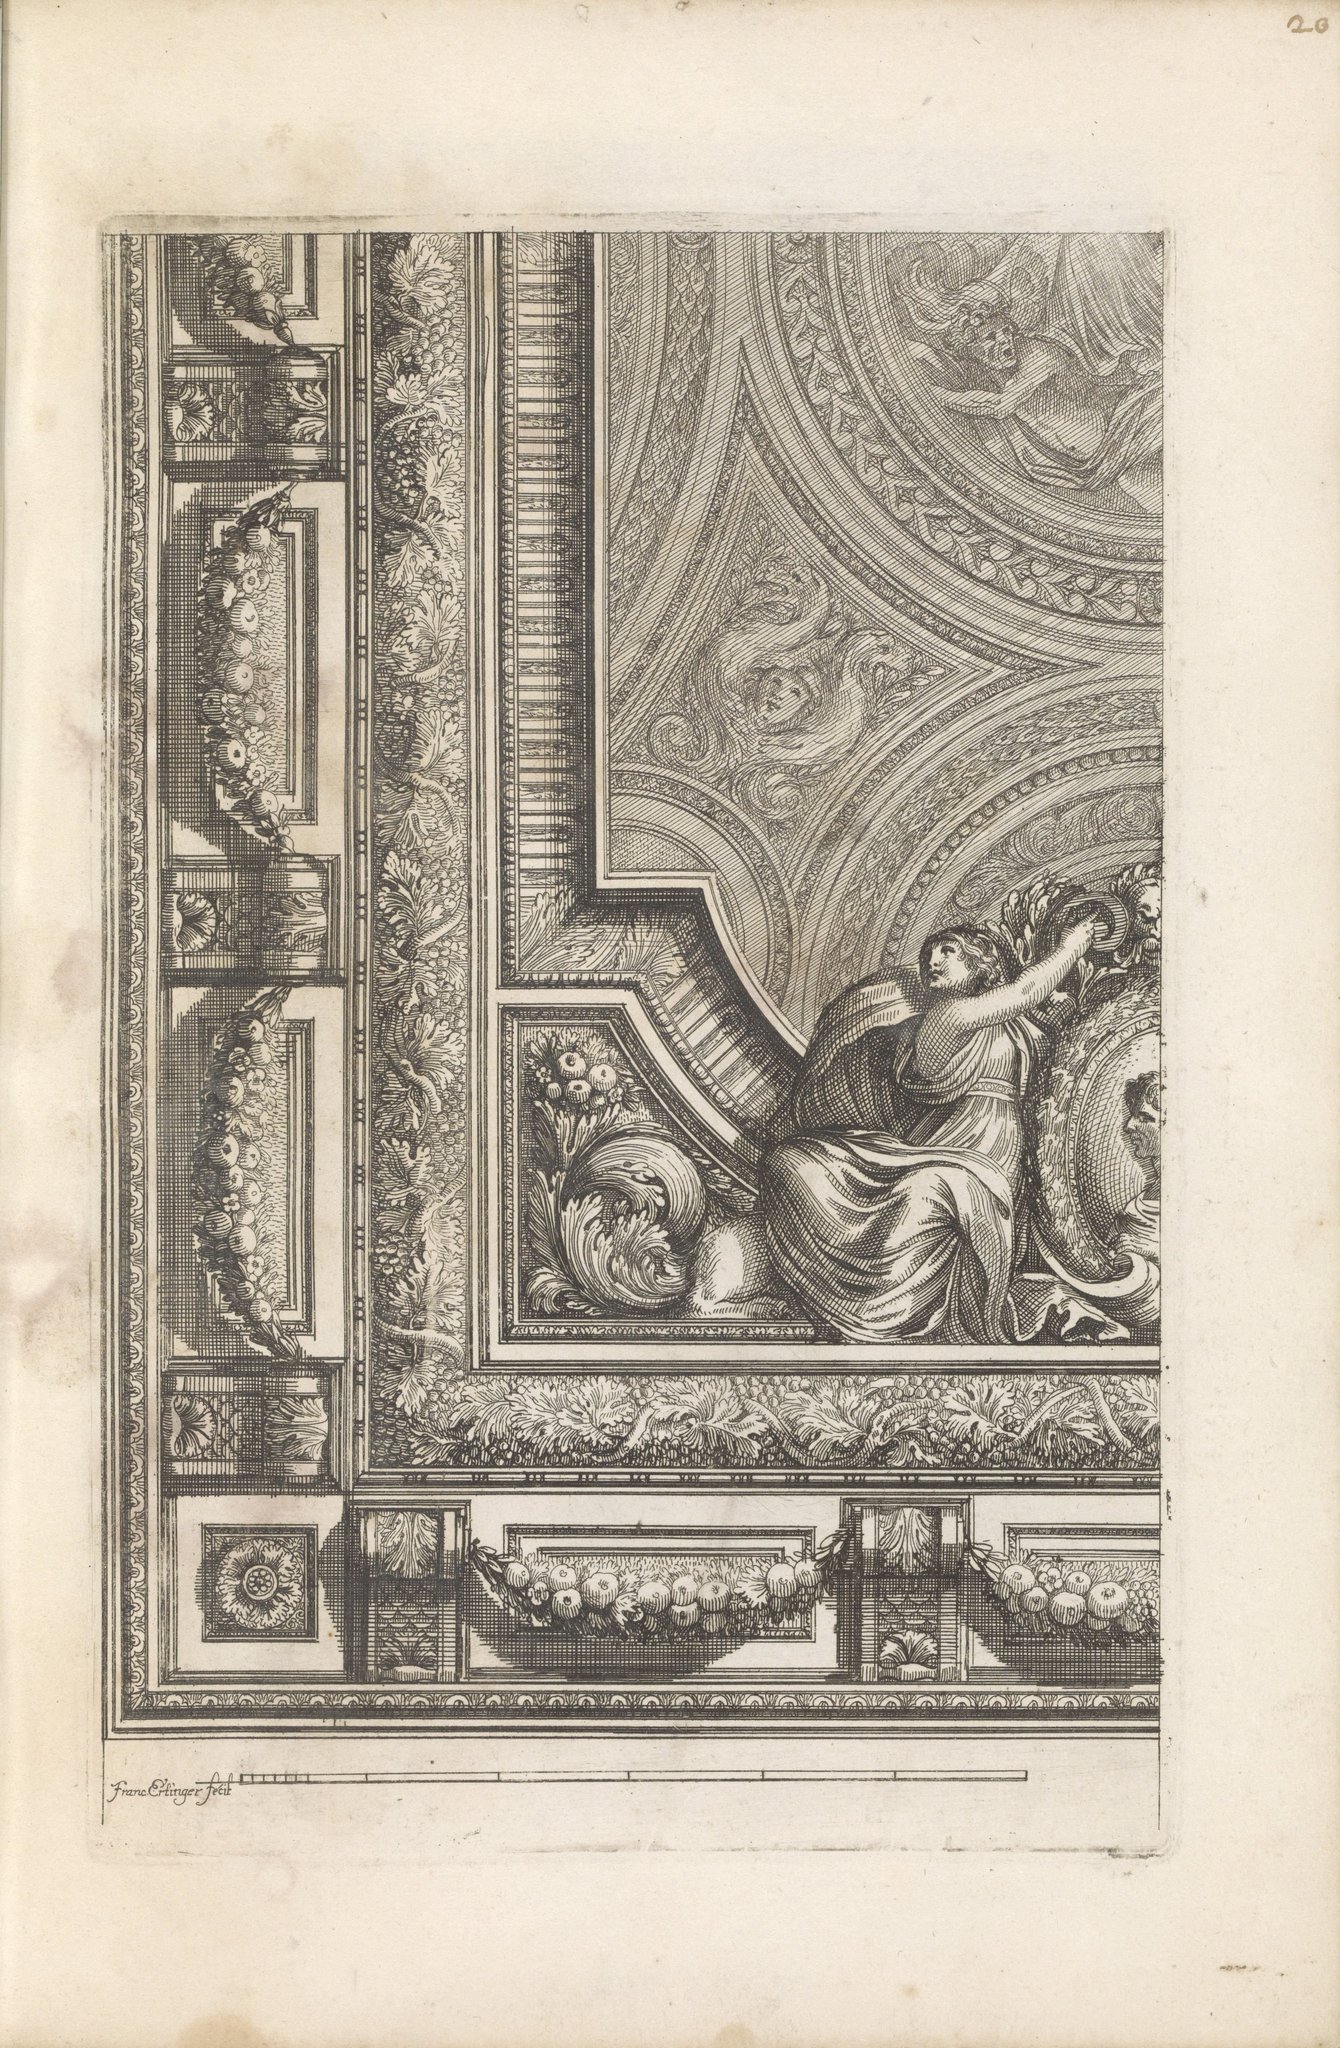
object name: album leaf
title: Quarts de plafons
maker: franz ertinger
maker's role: print maker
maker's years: 1640-1710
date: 1644-1710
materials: paper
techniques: etching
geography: paris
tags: ornaments ~ art, (decorated) ceiling, ornament ~ festoon, garland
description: Kwart plafond met een rand van alternerende consoles en rechthoekige panelen. De panelen ieder met een vruchtenguirlande. Uit serie van 6 bladen met tegenzijdige kopieën naar een serie Quarts de plafons van Jean Lepautre. Prent maakt deel uit van een album.